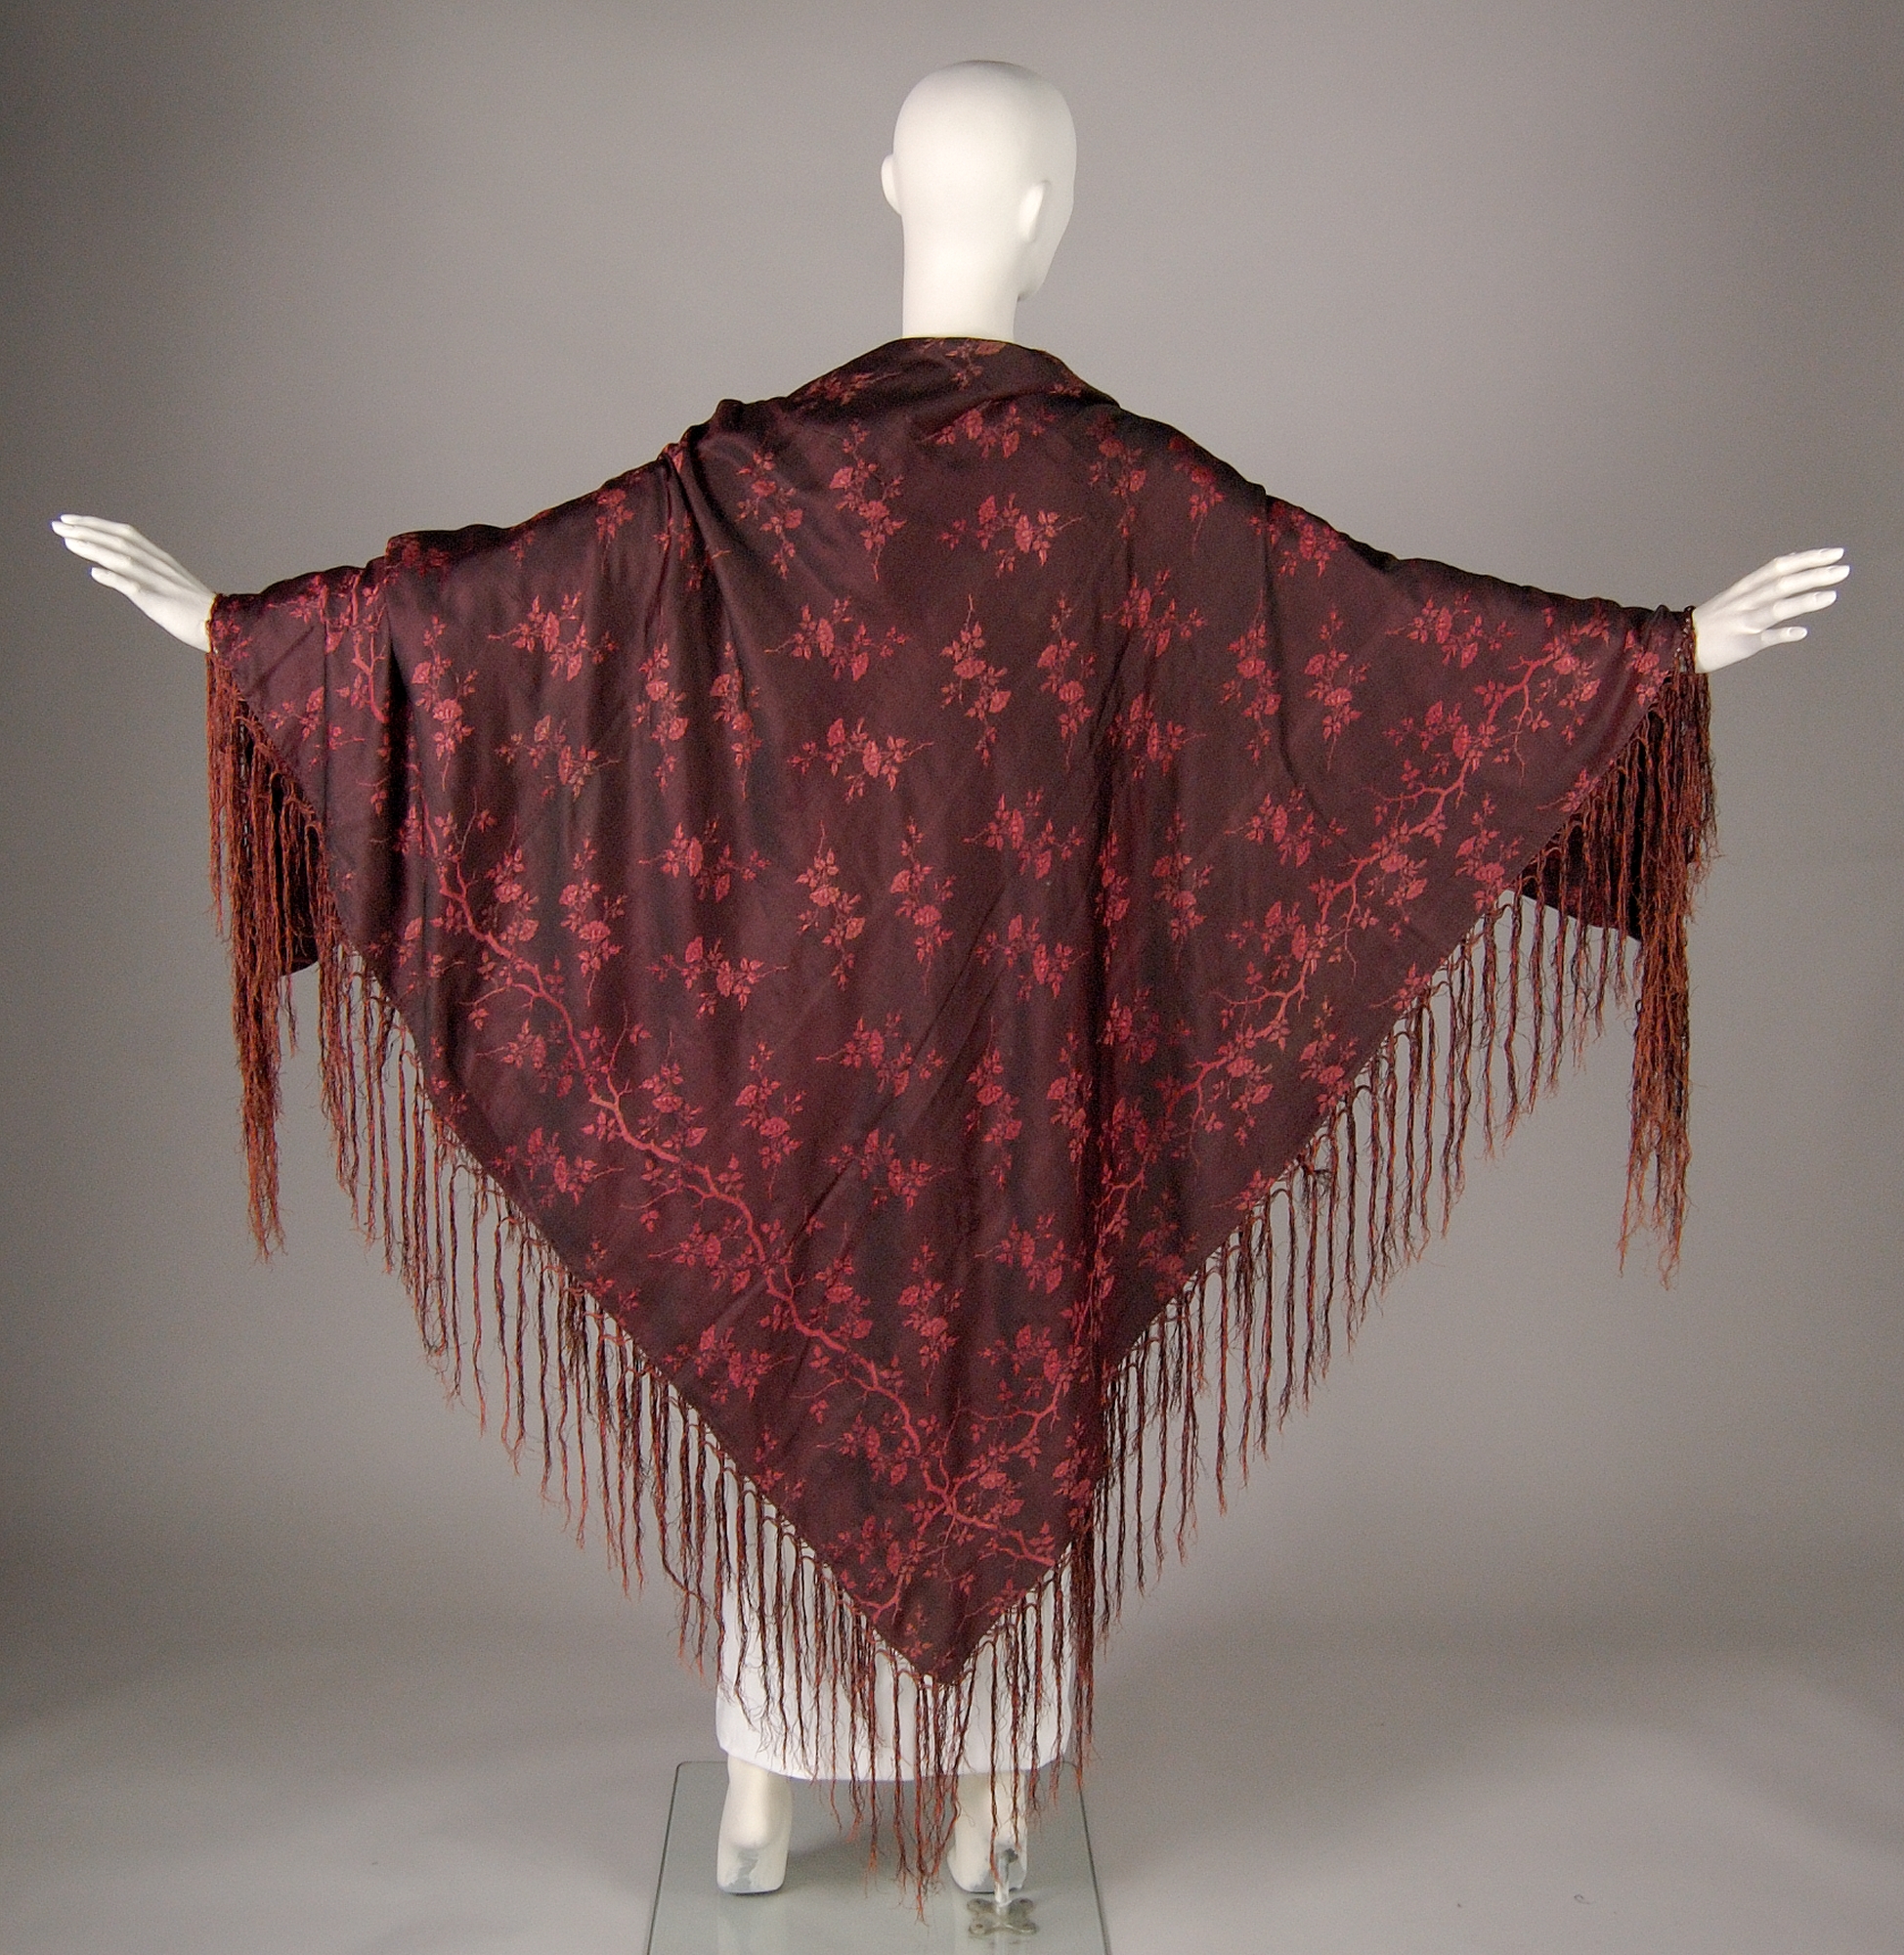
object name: shawl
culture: american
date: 1870-1890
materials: silk